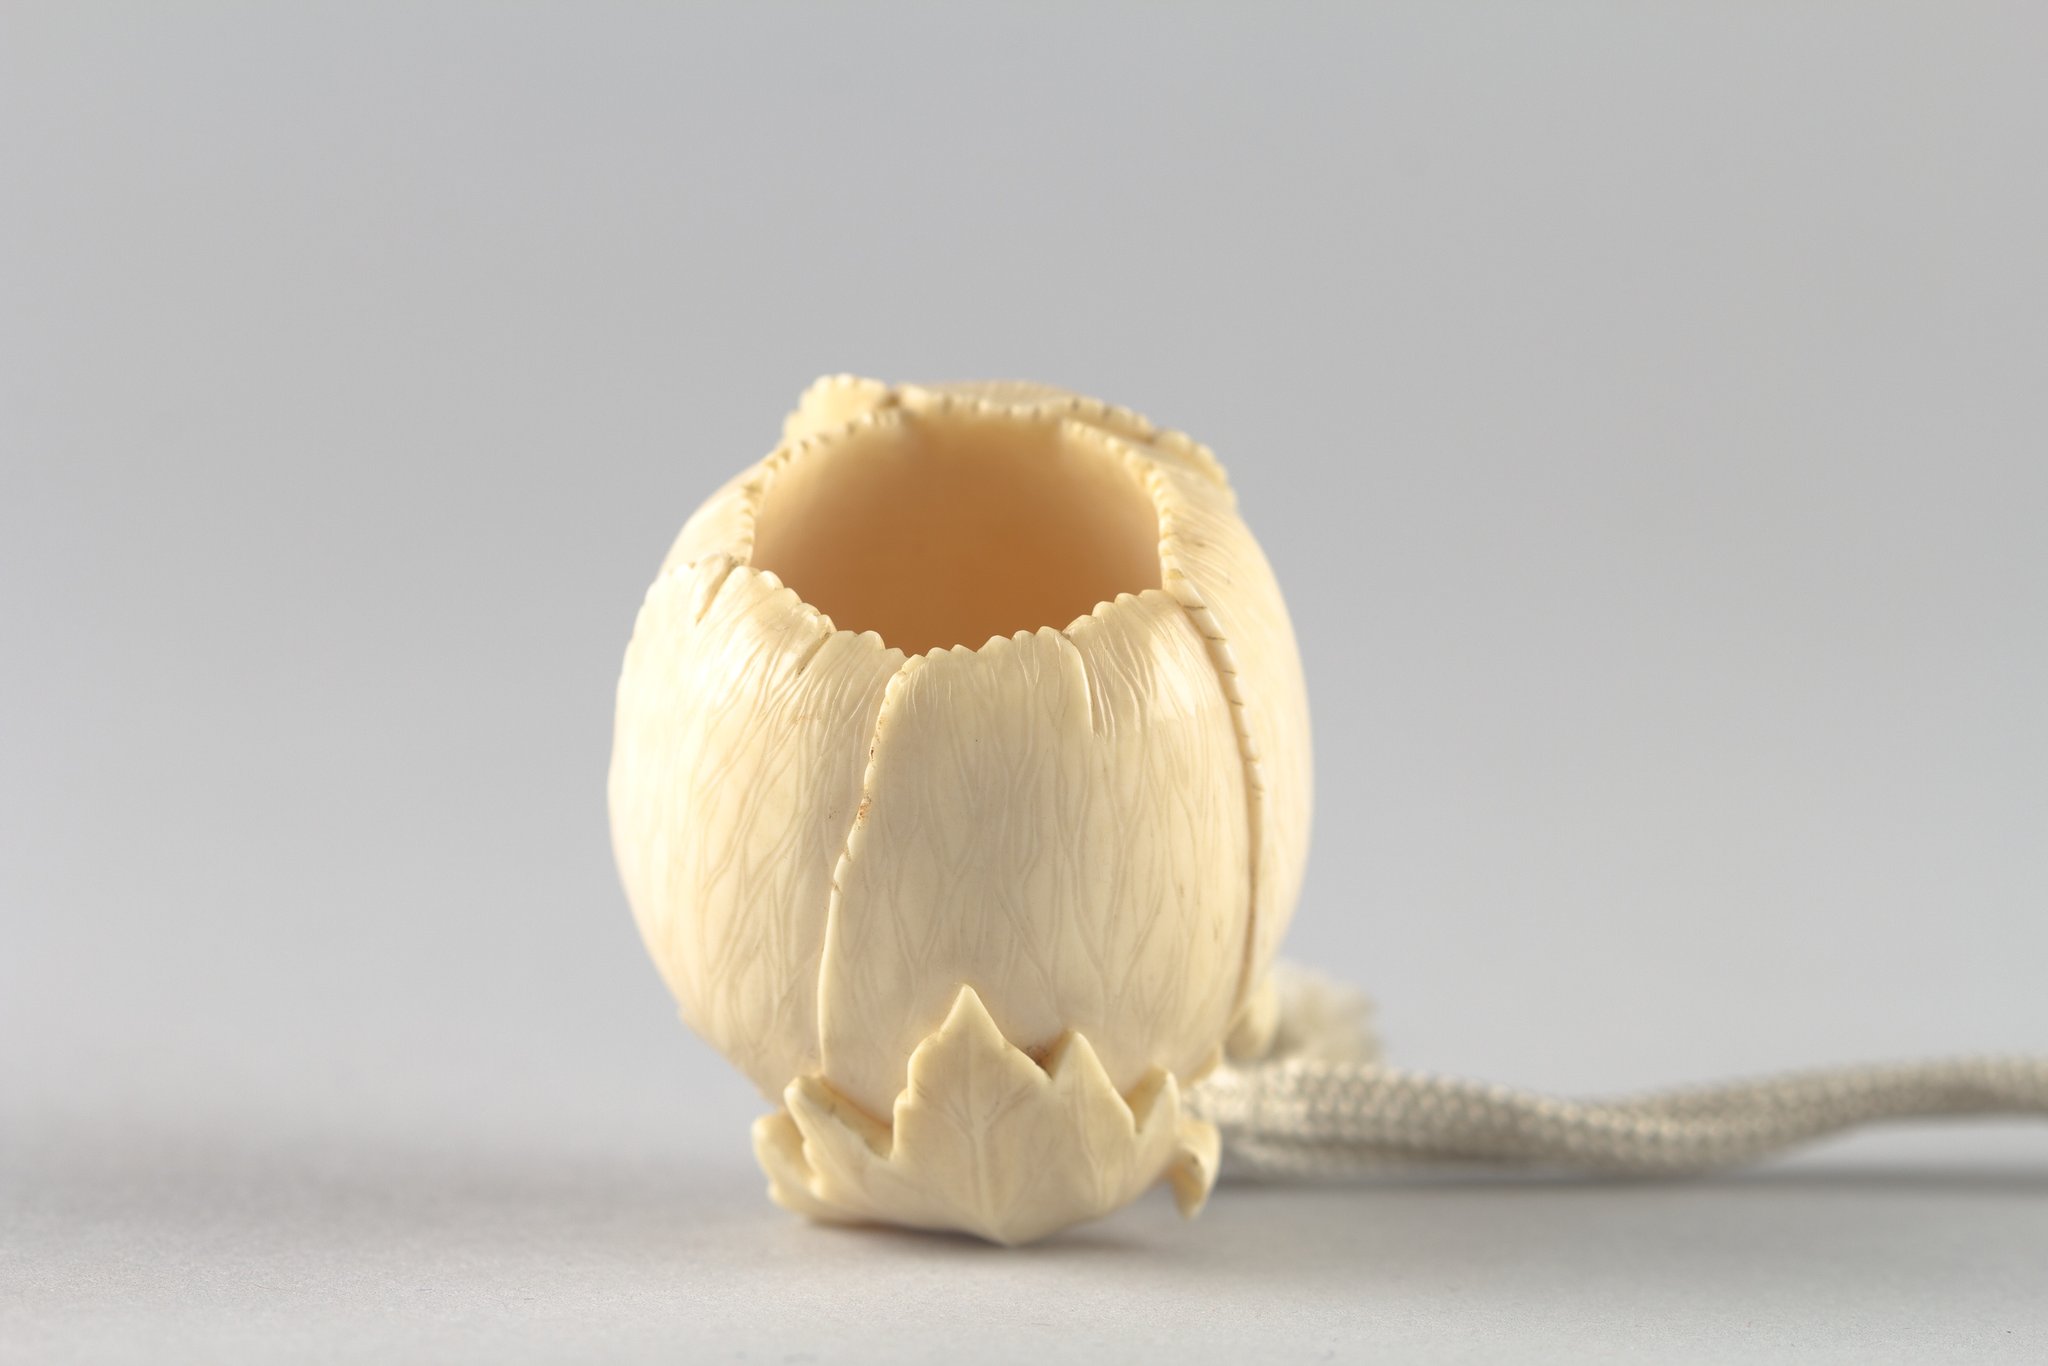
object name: netsuke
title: Netsuke of Blossom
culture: japanese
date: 1801-1900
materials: ivory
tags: flowers